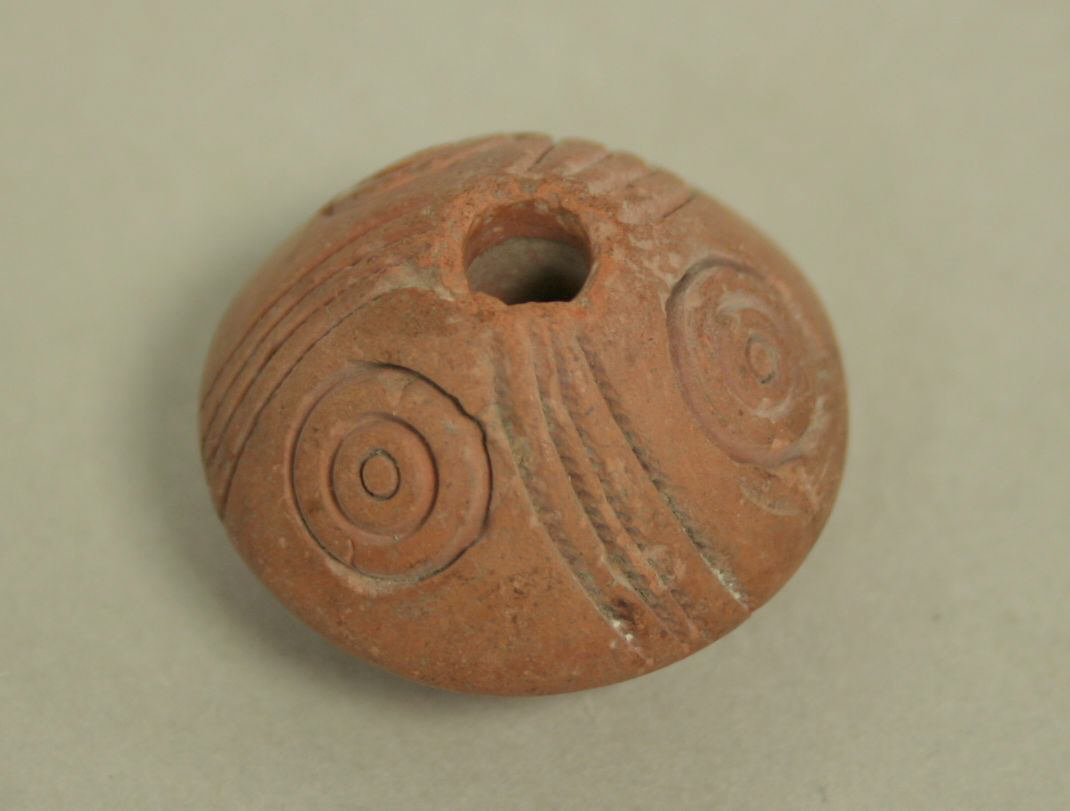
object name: spindle whorl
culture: peruvian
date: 1-500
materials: ceramic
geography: peru